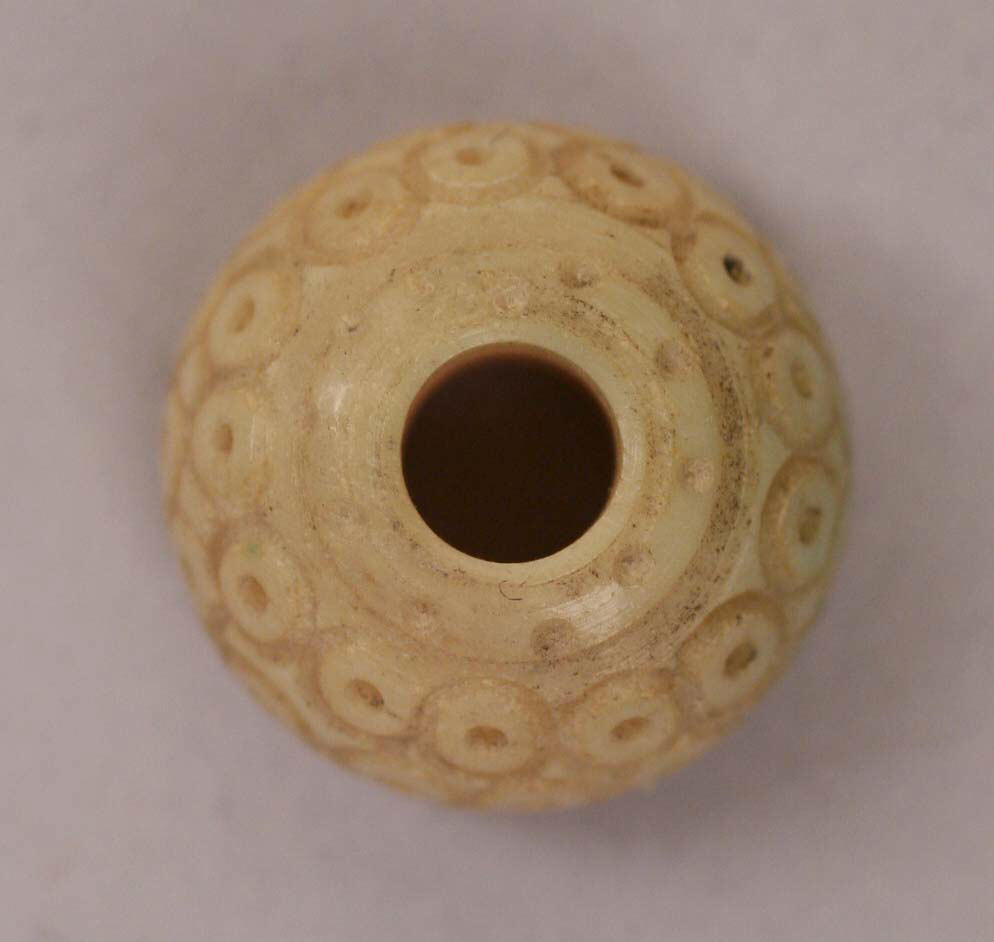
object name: button or bead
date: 801-1000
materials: bone, ivory, paint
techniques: incising, inlay, tinting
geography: iran